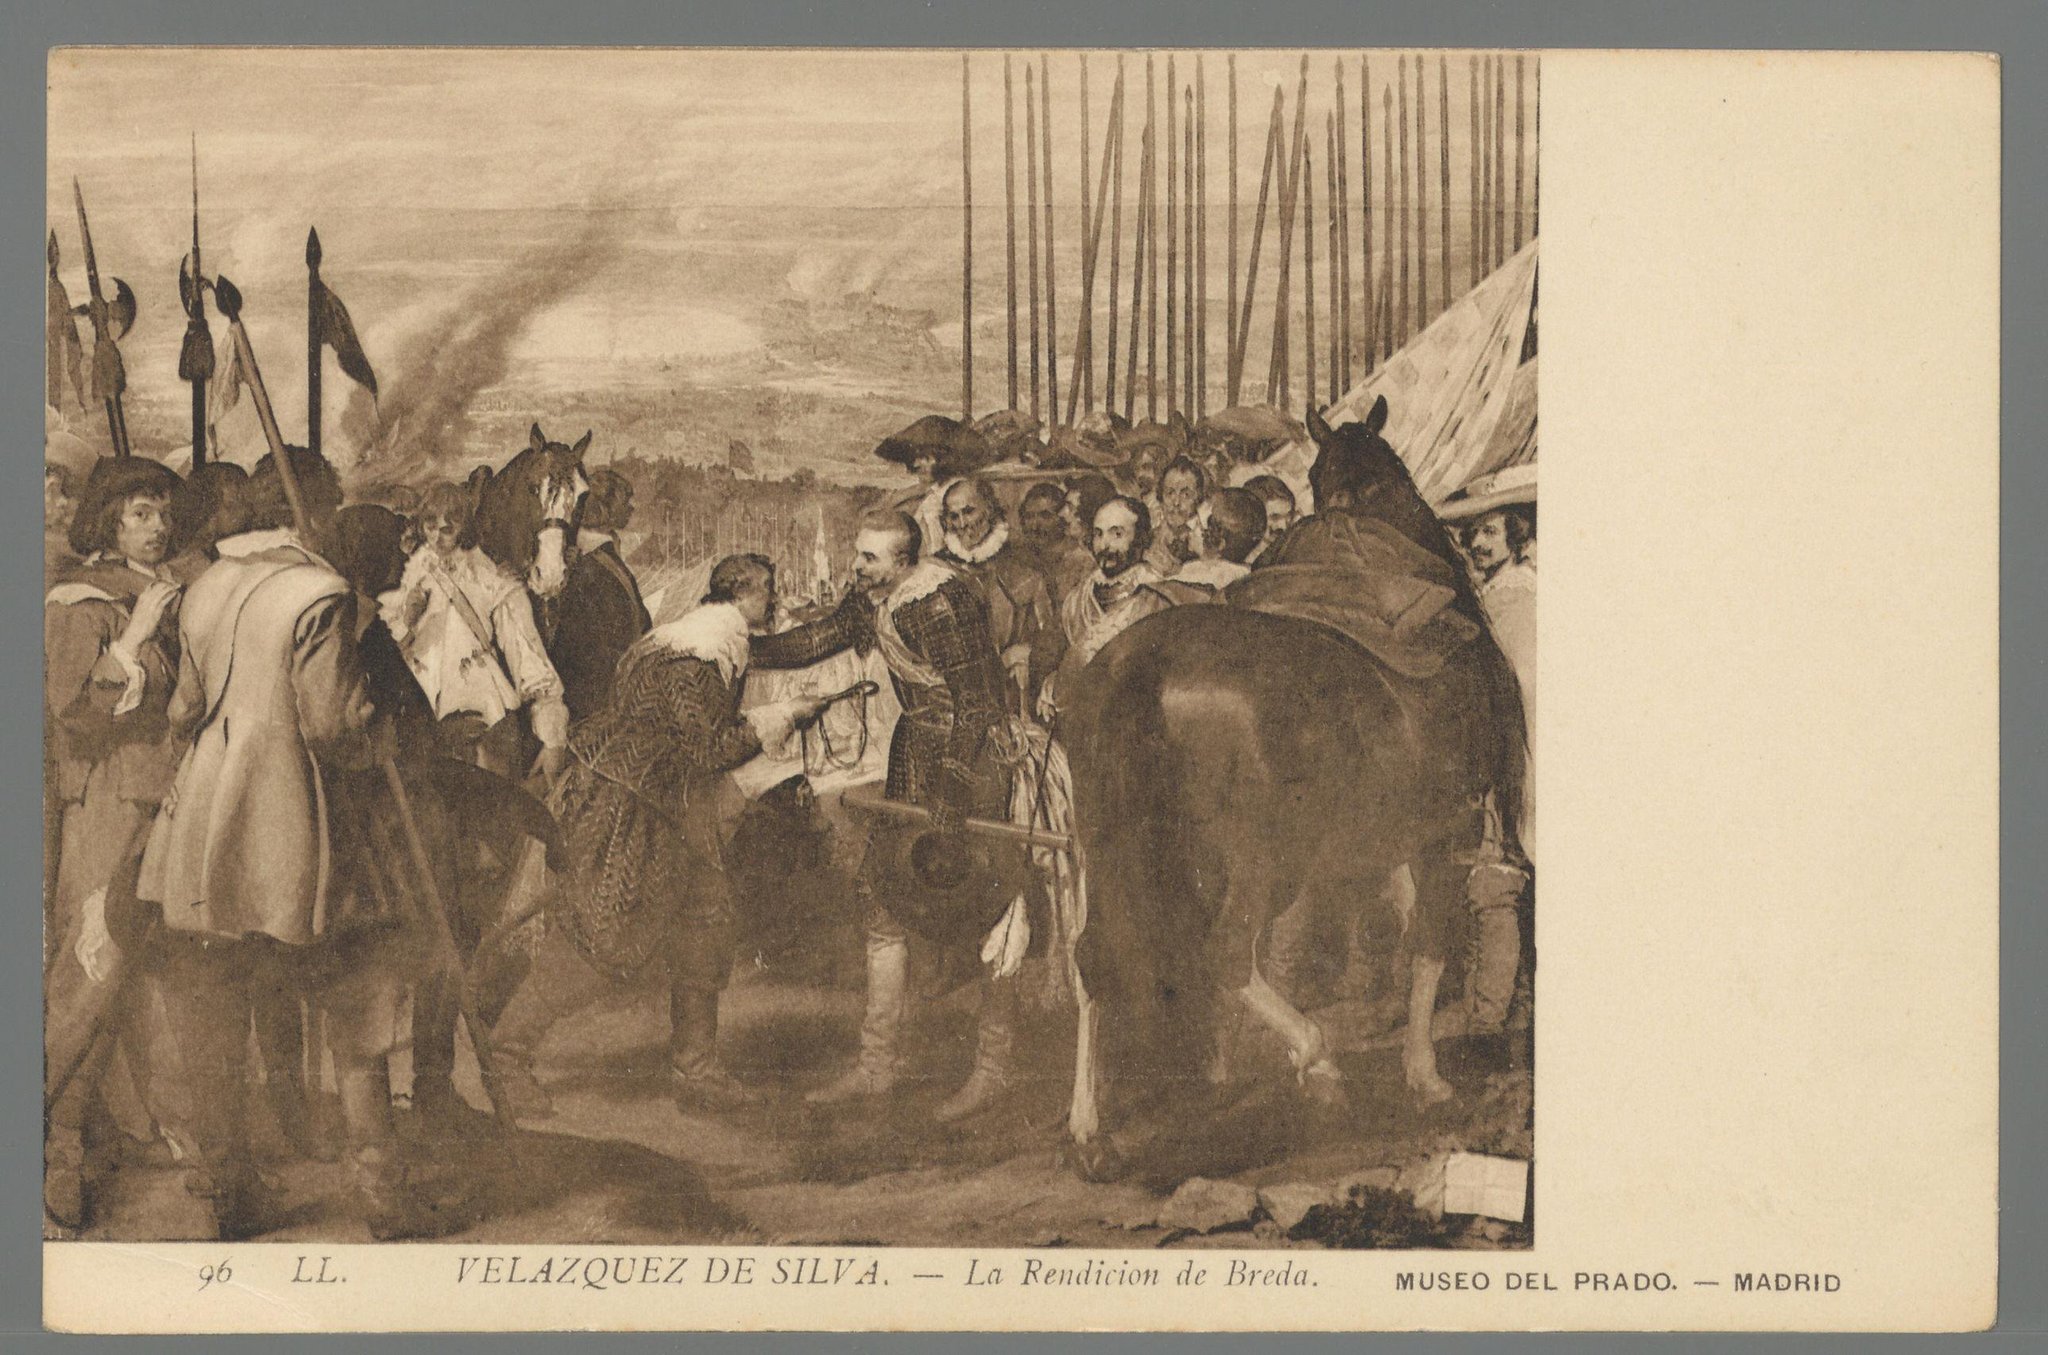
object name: reproduction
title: La Rendicion de Breda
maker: diego rodriguez de silva y velázquez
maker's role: painter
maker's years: 1599-1660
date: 1905-1920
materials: cardboard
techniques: photograph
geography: paris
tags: capture of city (after the siege), warfare; military affairs (+ infantry), horse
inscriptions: collector's mark: ‘AFE v S’